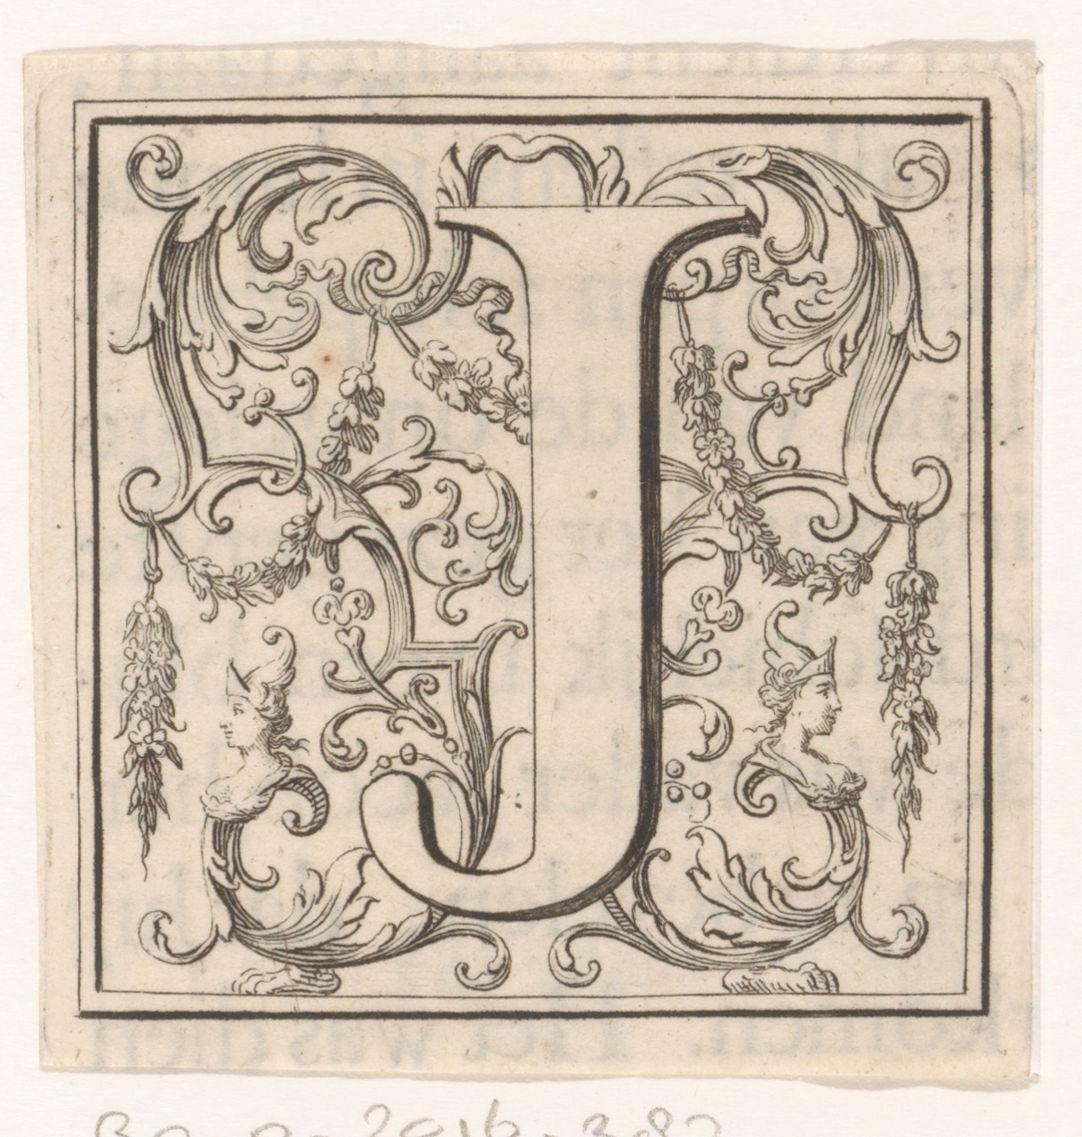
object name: ornament print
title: Letter J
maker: Anonymous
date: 1700-1799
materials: paper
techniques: etching, letterpress printing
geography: netherlands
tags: fancy letters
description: Letter J tegen een achtergrond met vlechtwerk en vrouwenbustes.